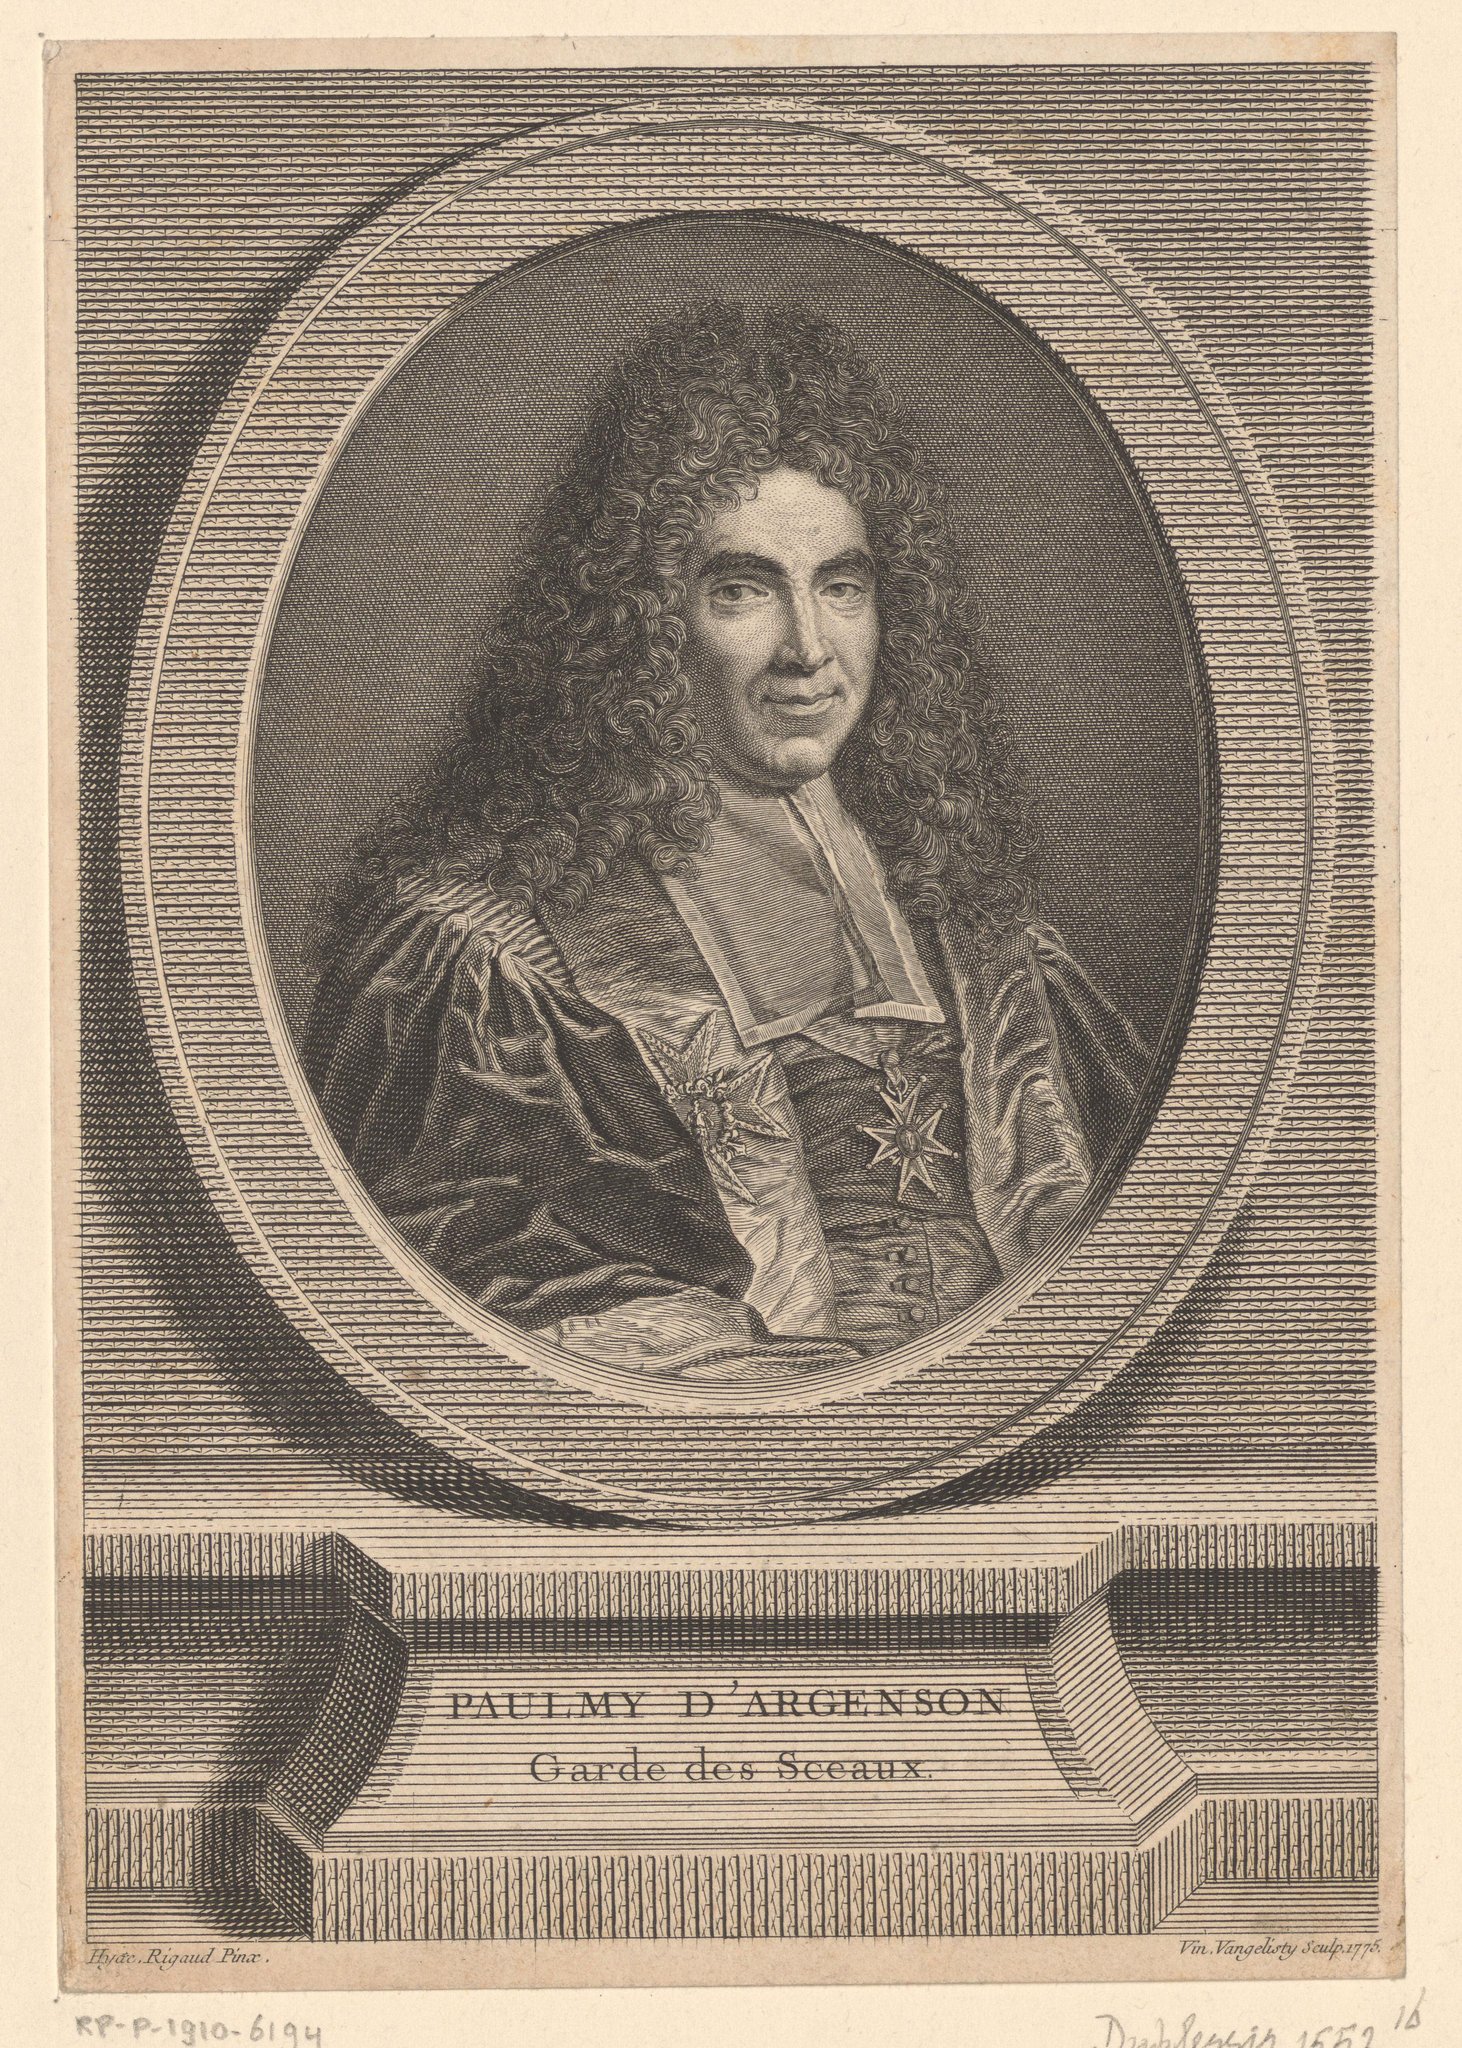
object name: print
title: Portret van Marc-René de Voyer de Paulmy, marquis d'Argenson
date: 1775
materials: paper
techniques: engraving, etching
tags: venice, paris, marc-rené de voyer de paulmy d’argenson markies d' voyer, historical persons, politician, e.g. party leader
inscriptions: collector's mark: Lugt 2228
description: Prent ook verschenen in: Turpin, François-Henri en Vincenzo Vangelisti. La France illustre ou le plutarque Français. Parijs: s.n., 1775[-1790].